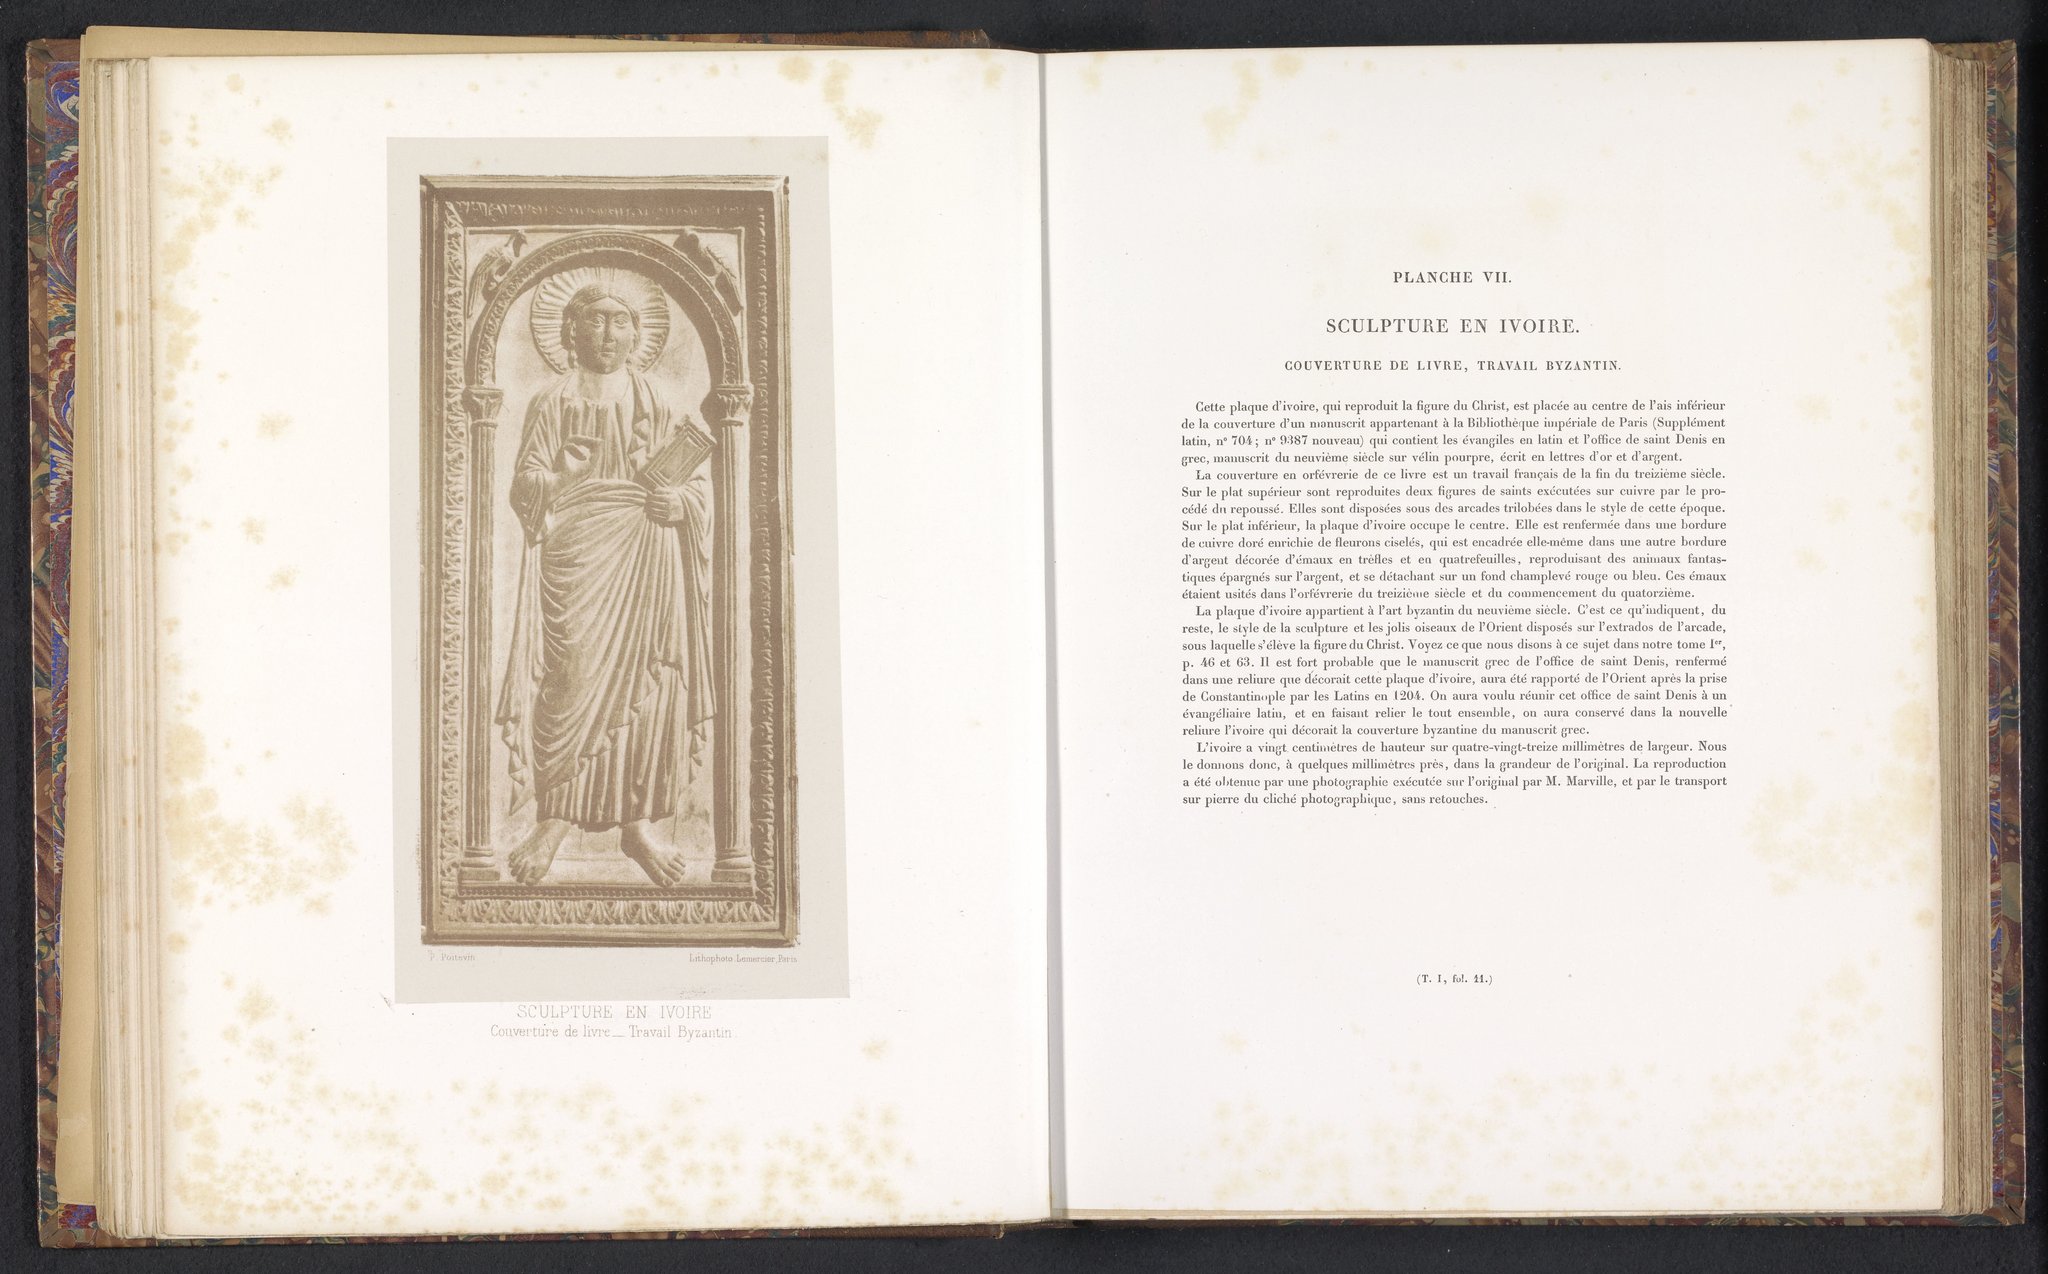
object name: photomechanical print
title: Sculpture en ivoire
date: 1859-1864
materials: paper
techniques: photolithography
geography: paris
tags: christ, sculpture (+ relief ~ sculpture)